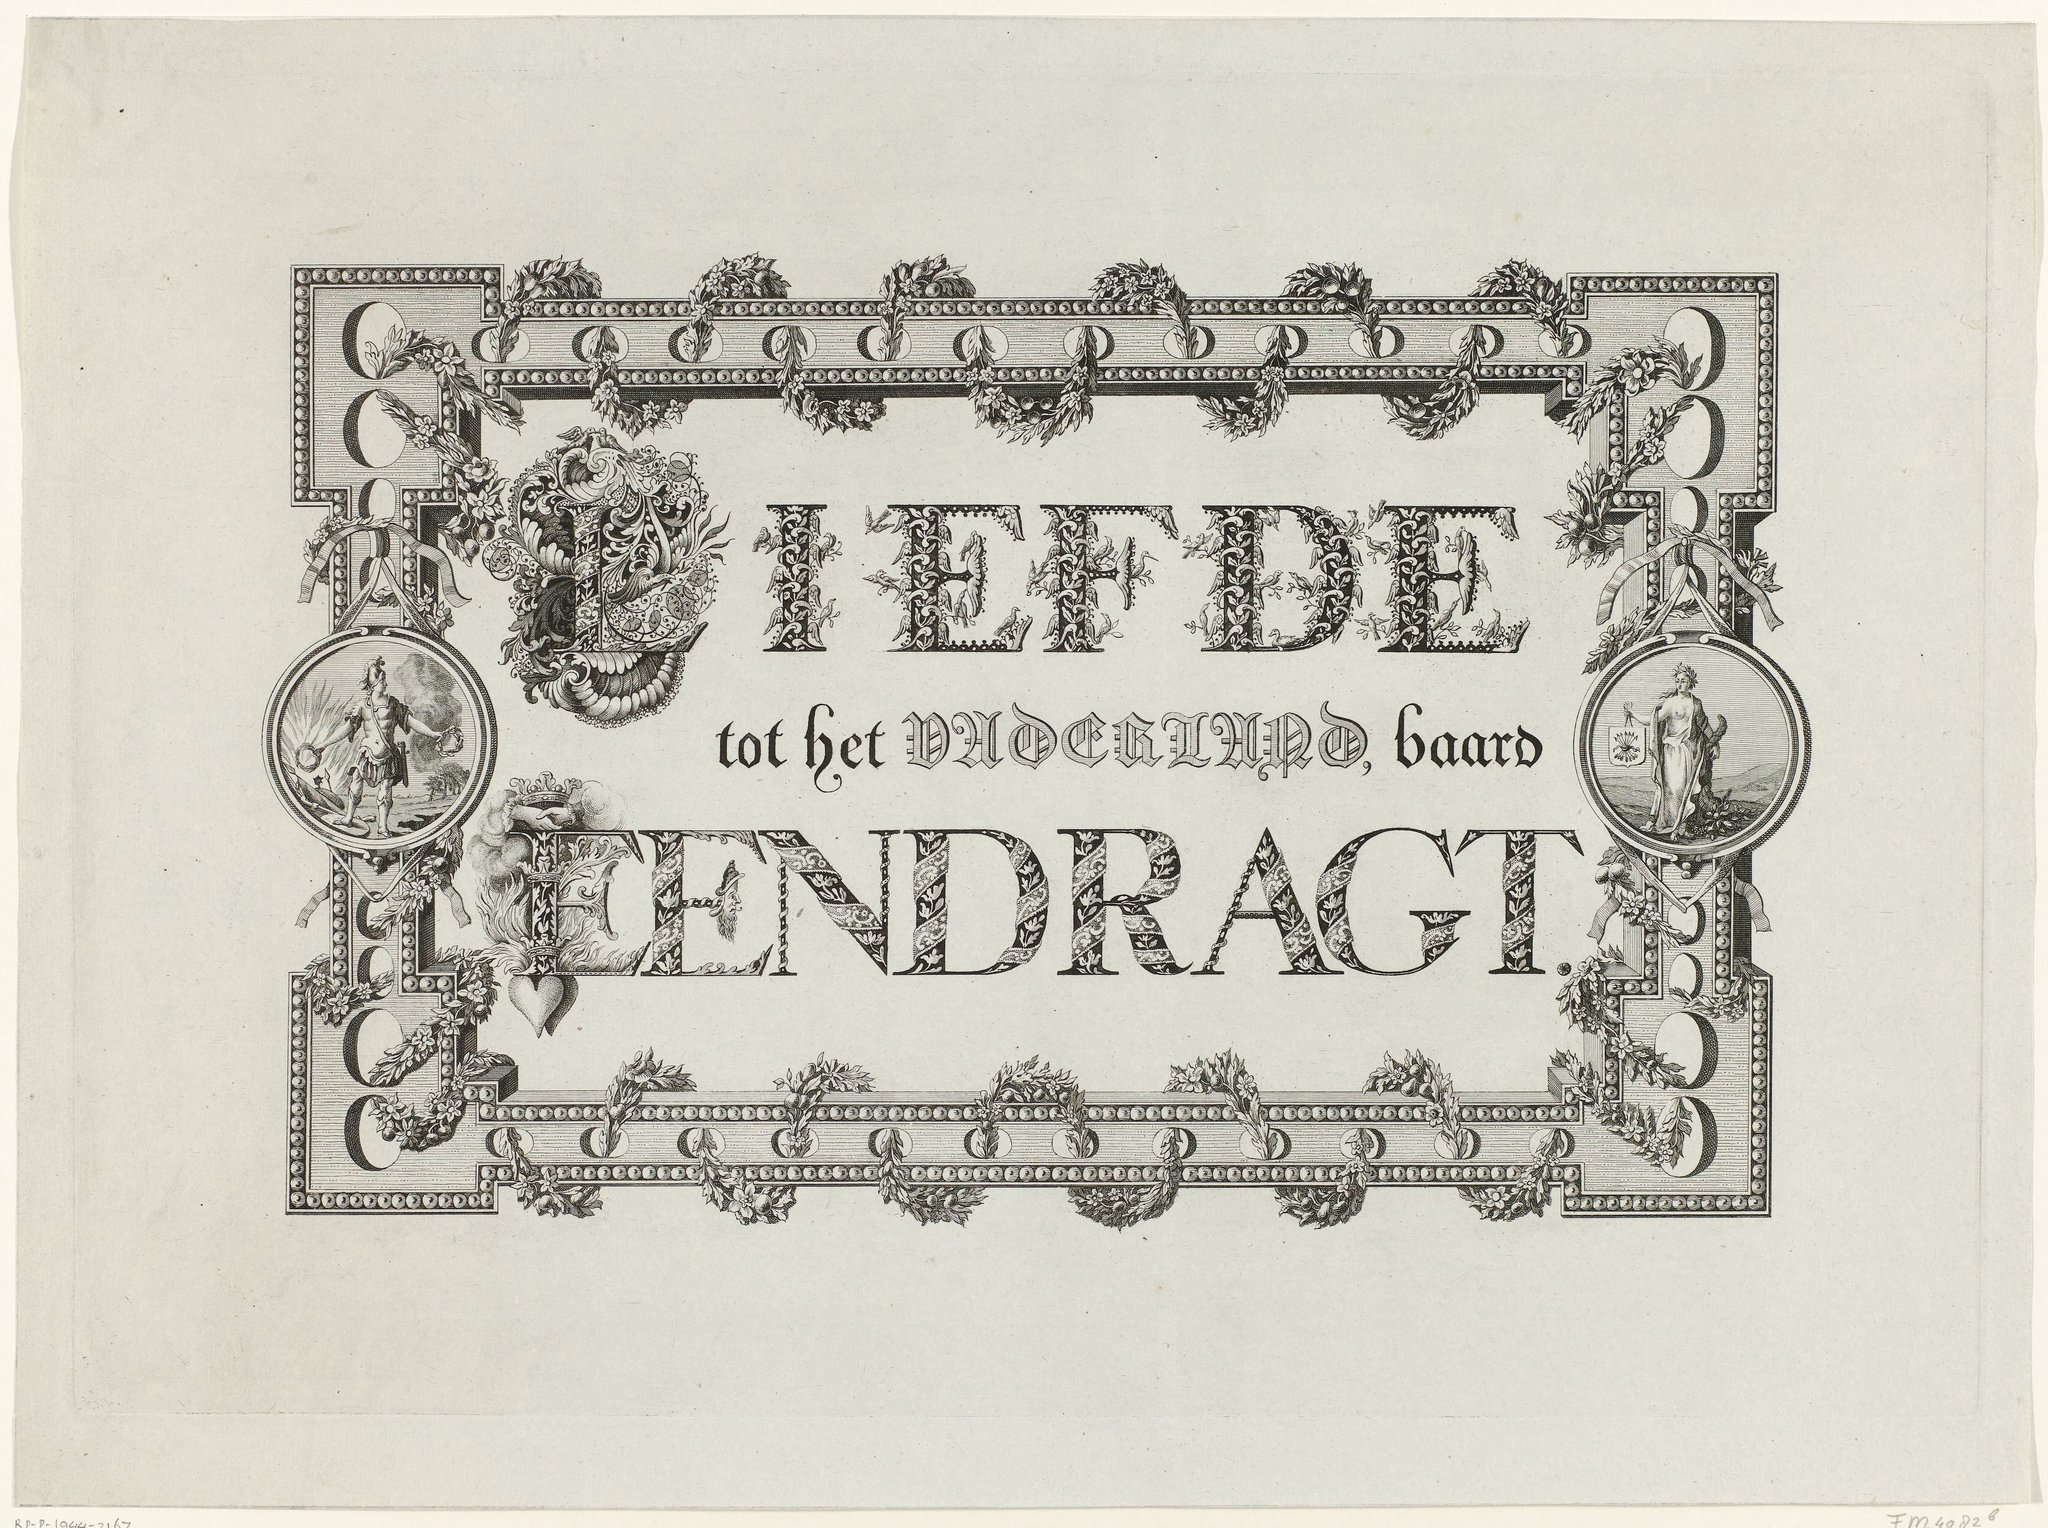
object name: calligraphy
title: Kalligrafie op de eendracht van het land, 1787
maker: leonard jozef ferrier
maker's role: silversmith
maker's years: 1726-1801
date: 1787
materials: paper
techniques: engraving, etching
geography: northern netherlands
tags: calligraphy, netherlands, patriots (1780-1795)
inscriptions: collector's mark: Lugt 2228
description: Kalligrafische allegorie op de eendracht van het land, 1787. Met twee allegorische medaillons op de eendracht.